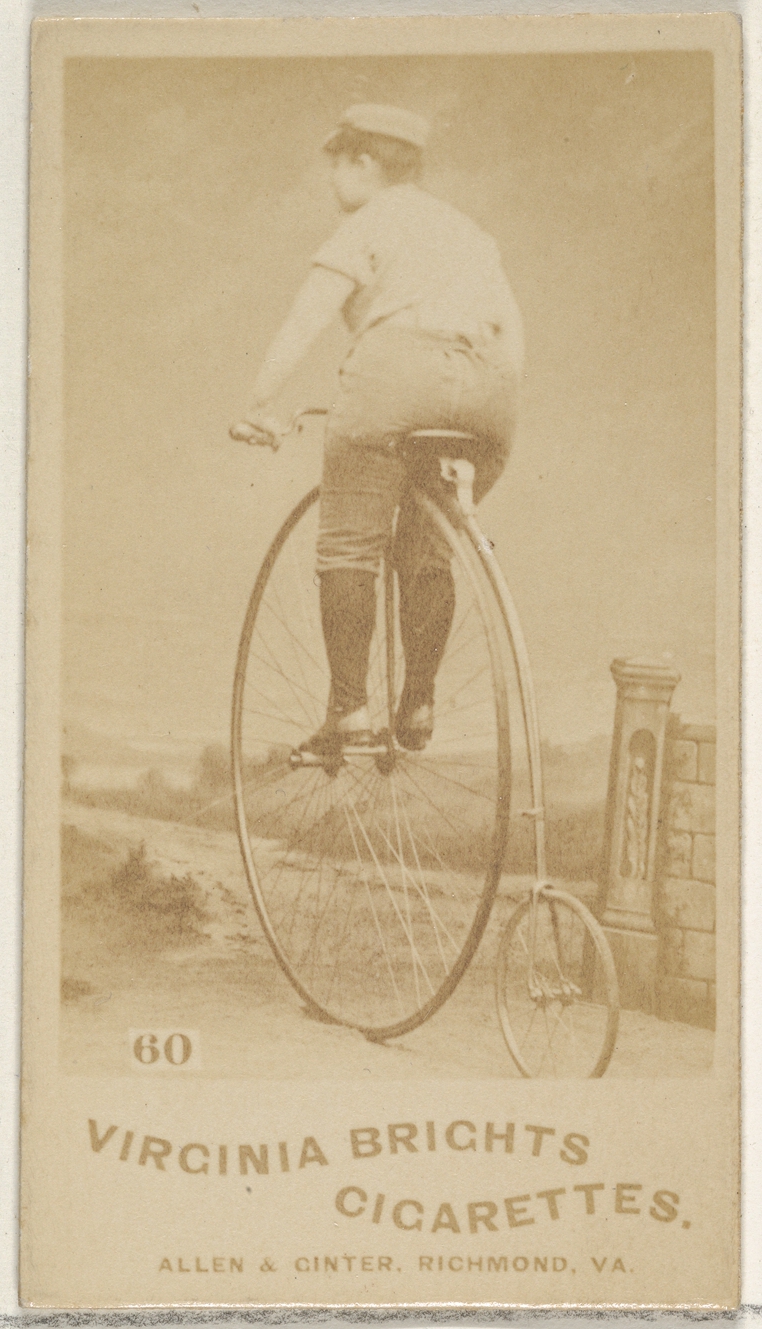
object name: photograph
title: Card 60, from the Girl Cyclists series (N49) for Virginia Brights Cigarettes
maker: allen & ginter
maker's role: publisher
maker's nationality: american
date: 1887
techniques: albumen silver print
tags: girls,bicycles